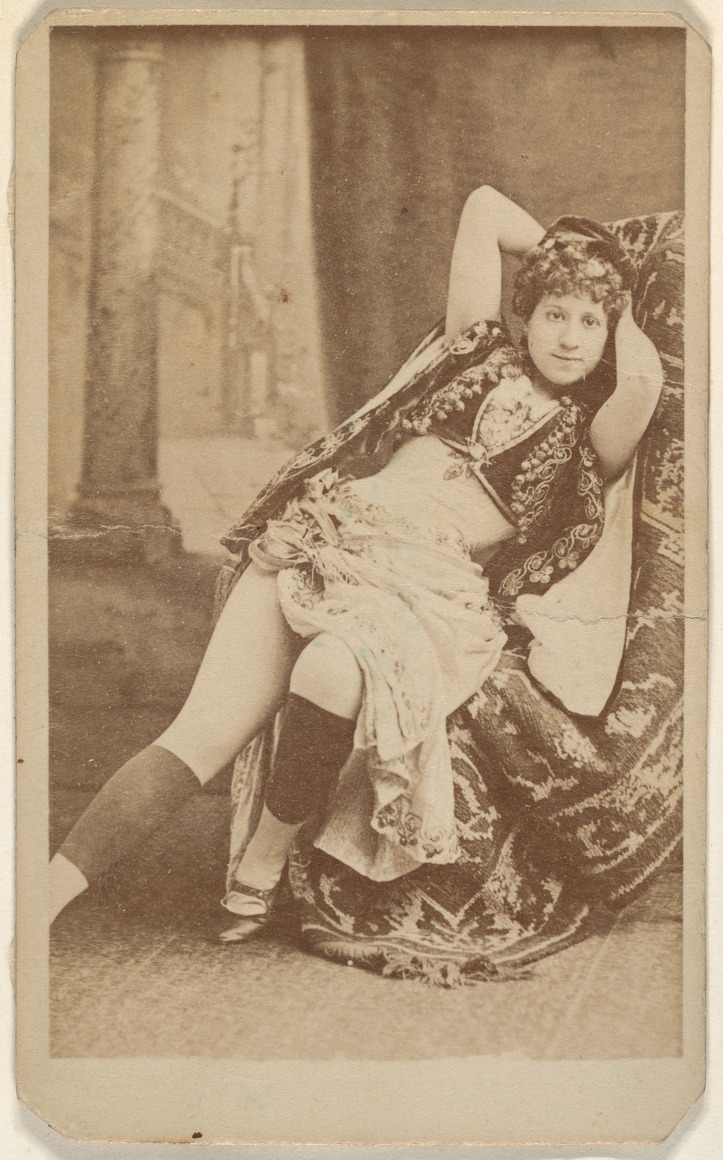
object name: photograph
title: Reclining actress, from the Actresses series (N668)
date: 1888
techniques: albumen silver print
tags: portraits,women,actresses